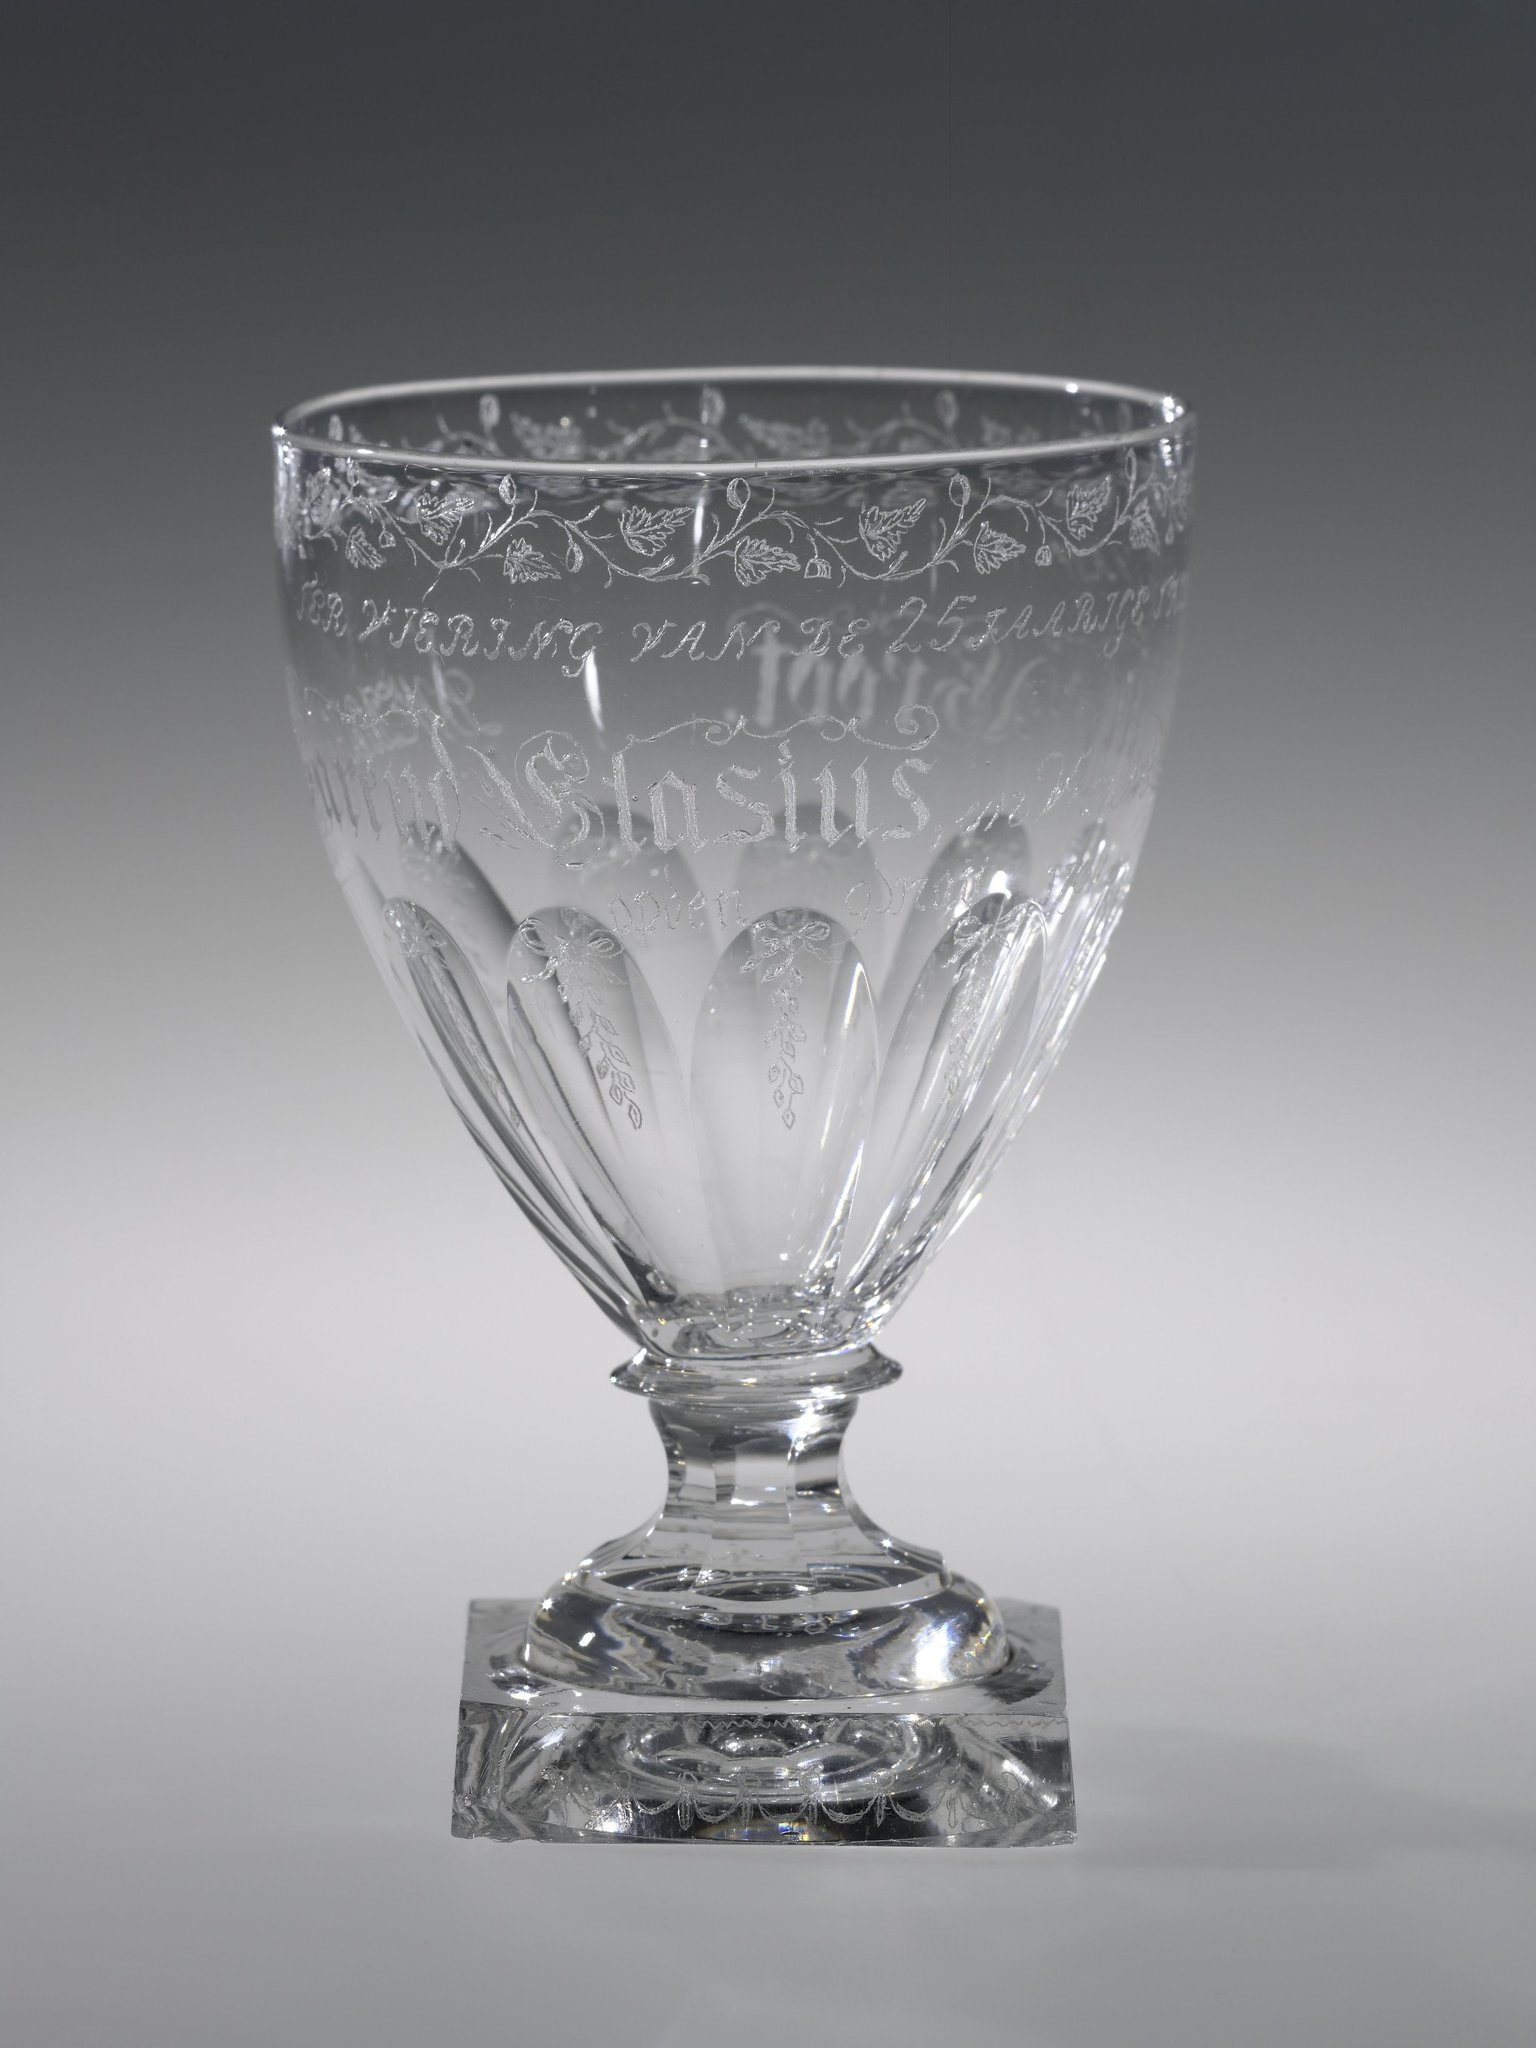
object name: goblet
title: Kelkglas op vierkante basis op het 25-jarig huwelijk van Barend Glasius en Grietje de Groot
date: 1791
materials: glass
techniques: diamond point engraving, glassblowing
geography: northern netherlands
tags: amsterdam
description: Kelkglas op gewelfde voet op vierkante basis. Korte, gefacetteerde stam. Gebogen kelk met gefacetteerde bodem. Op de kelk de gegraveerde tekst: TER VIERING VAN DE 25 JAARIGE trouwdag,van // DWEDLe Heer BAREND GLASIUS en Vrouwe GRIETJE de GROOT. // op den 9 maij 1791.